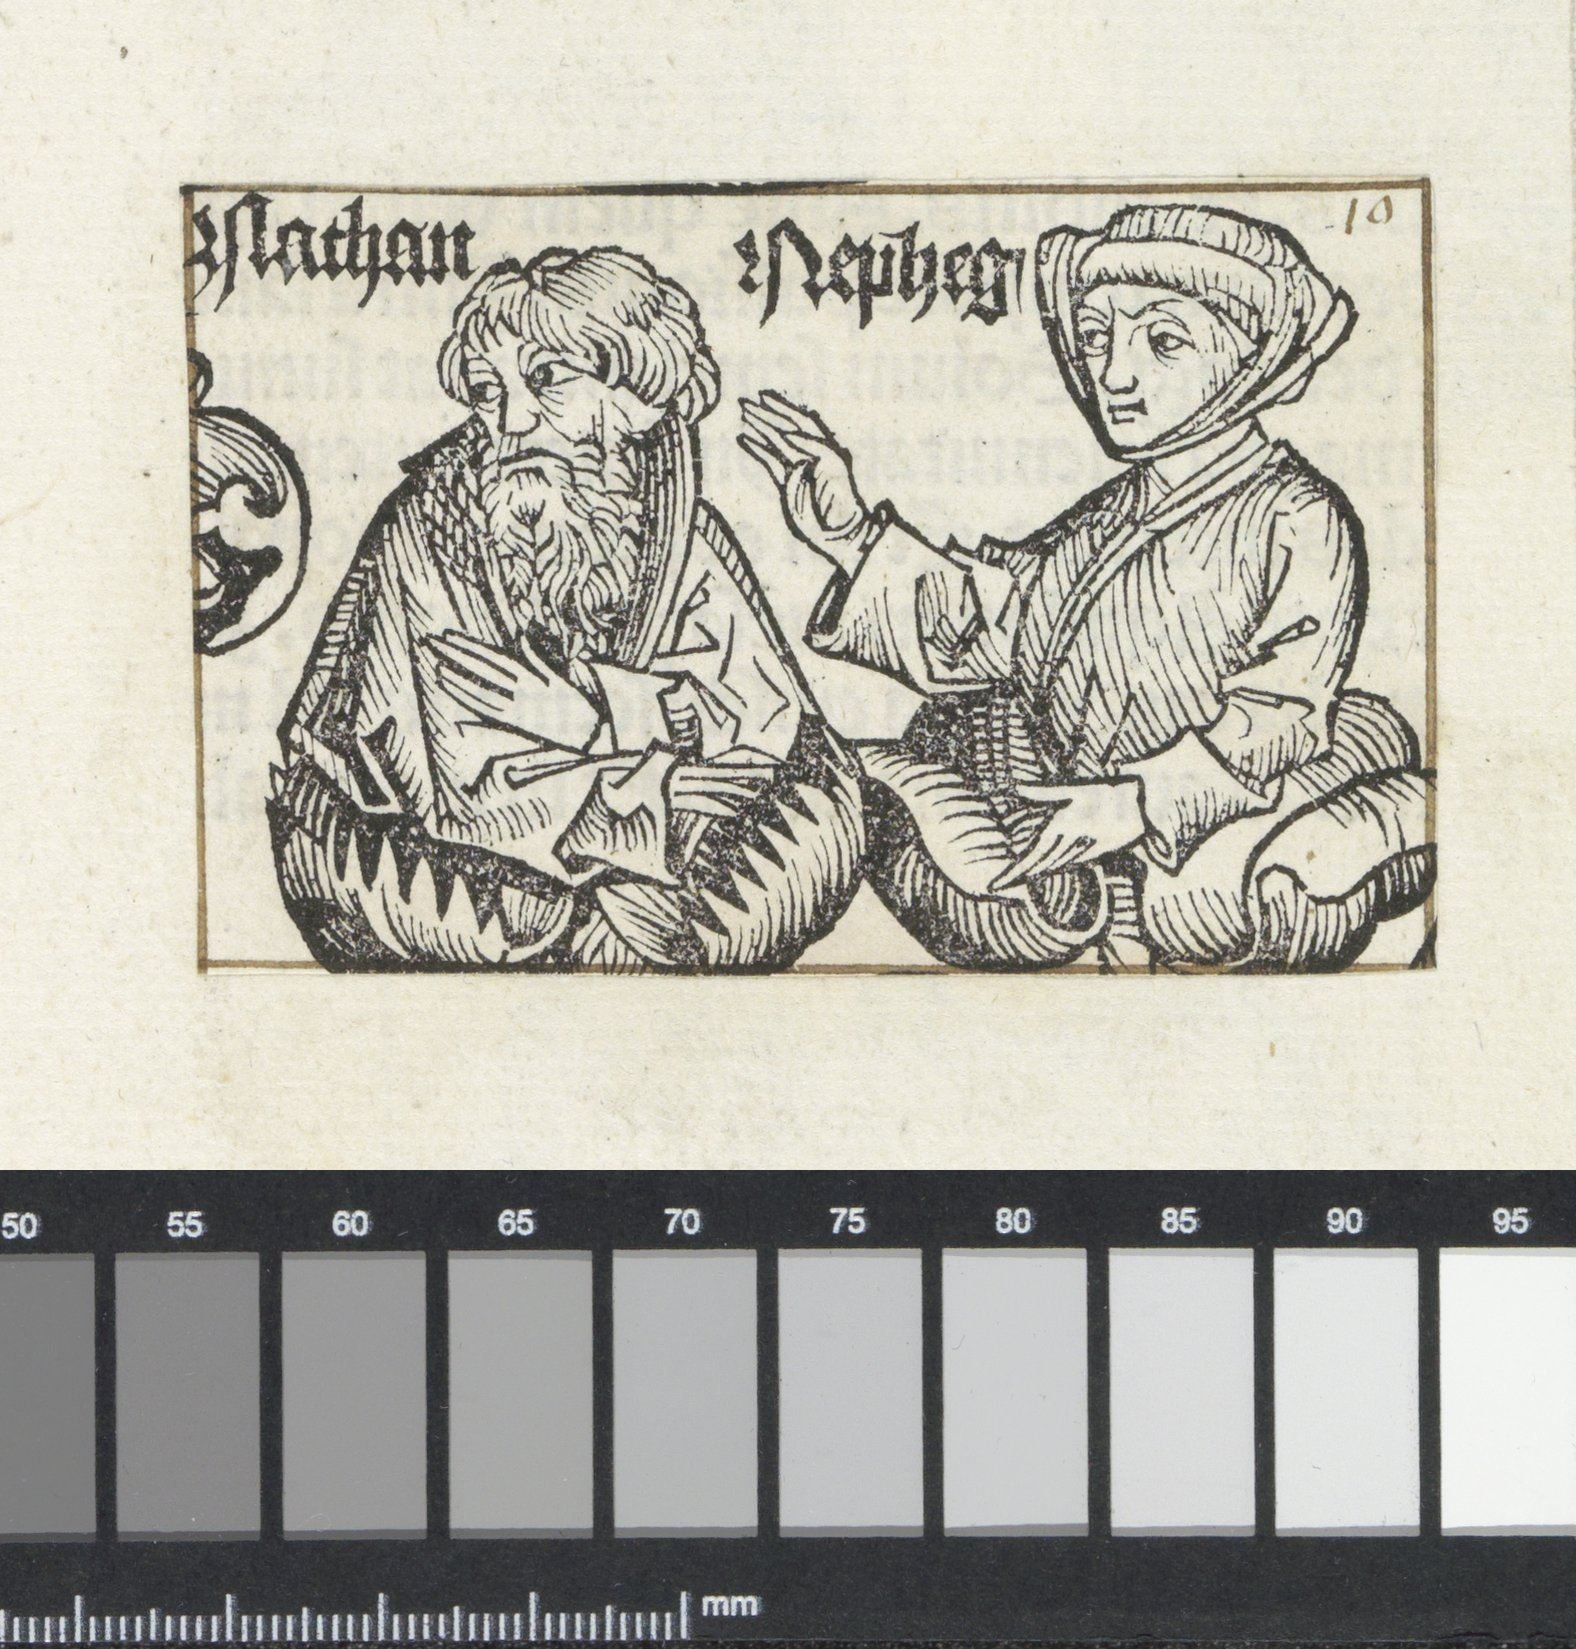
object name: book illustration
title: Liber Chronicarum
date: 1493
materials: paper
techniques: letterpress printing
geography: nuremberg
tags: persons from the old testament (not in biblical context, nor occurring in legendary/historical extensions included in division 71)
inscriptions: inscription: ‘10’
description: Twee bloemkelken met twee mannen. De voorstelling is een fragment van de stamboom van Christus in de Liber Chronicarum. De tekst identificeert de mannen als geïdentificeerd als Natan een Nefeg, zonen van koning David geboren te Jeruzalem (2 Sam. 5: 14-16). De prent maakt deel uit van een album.